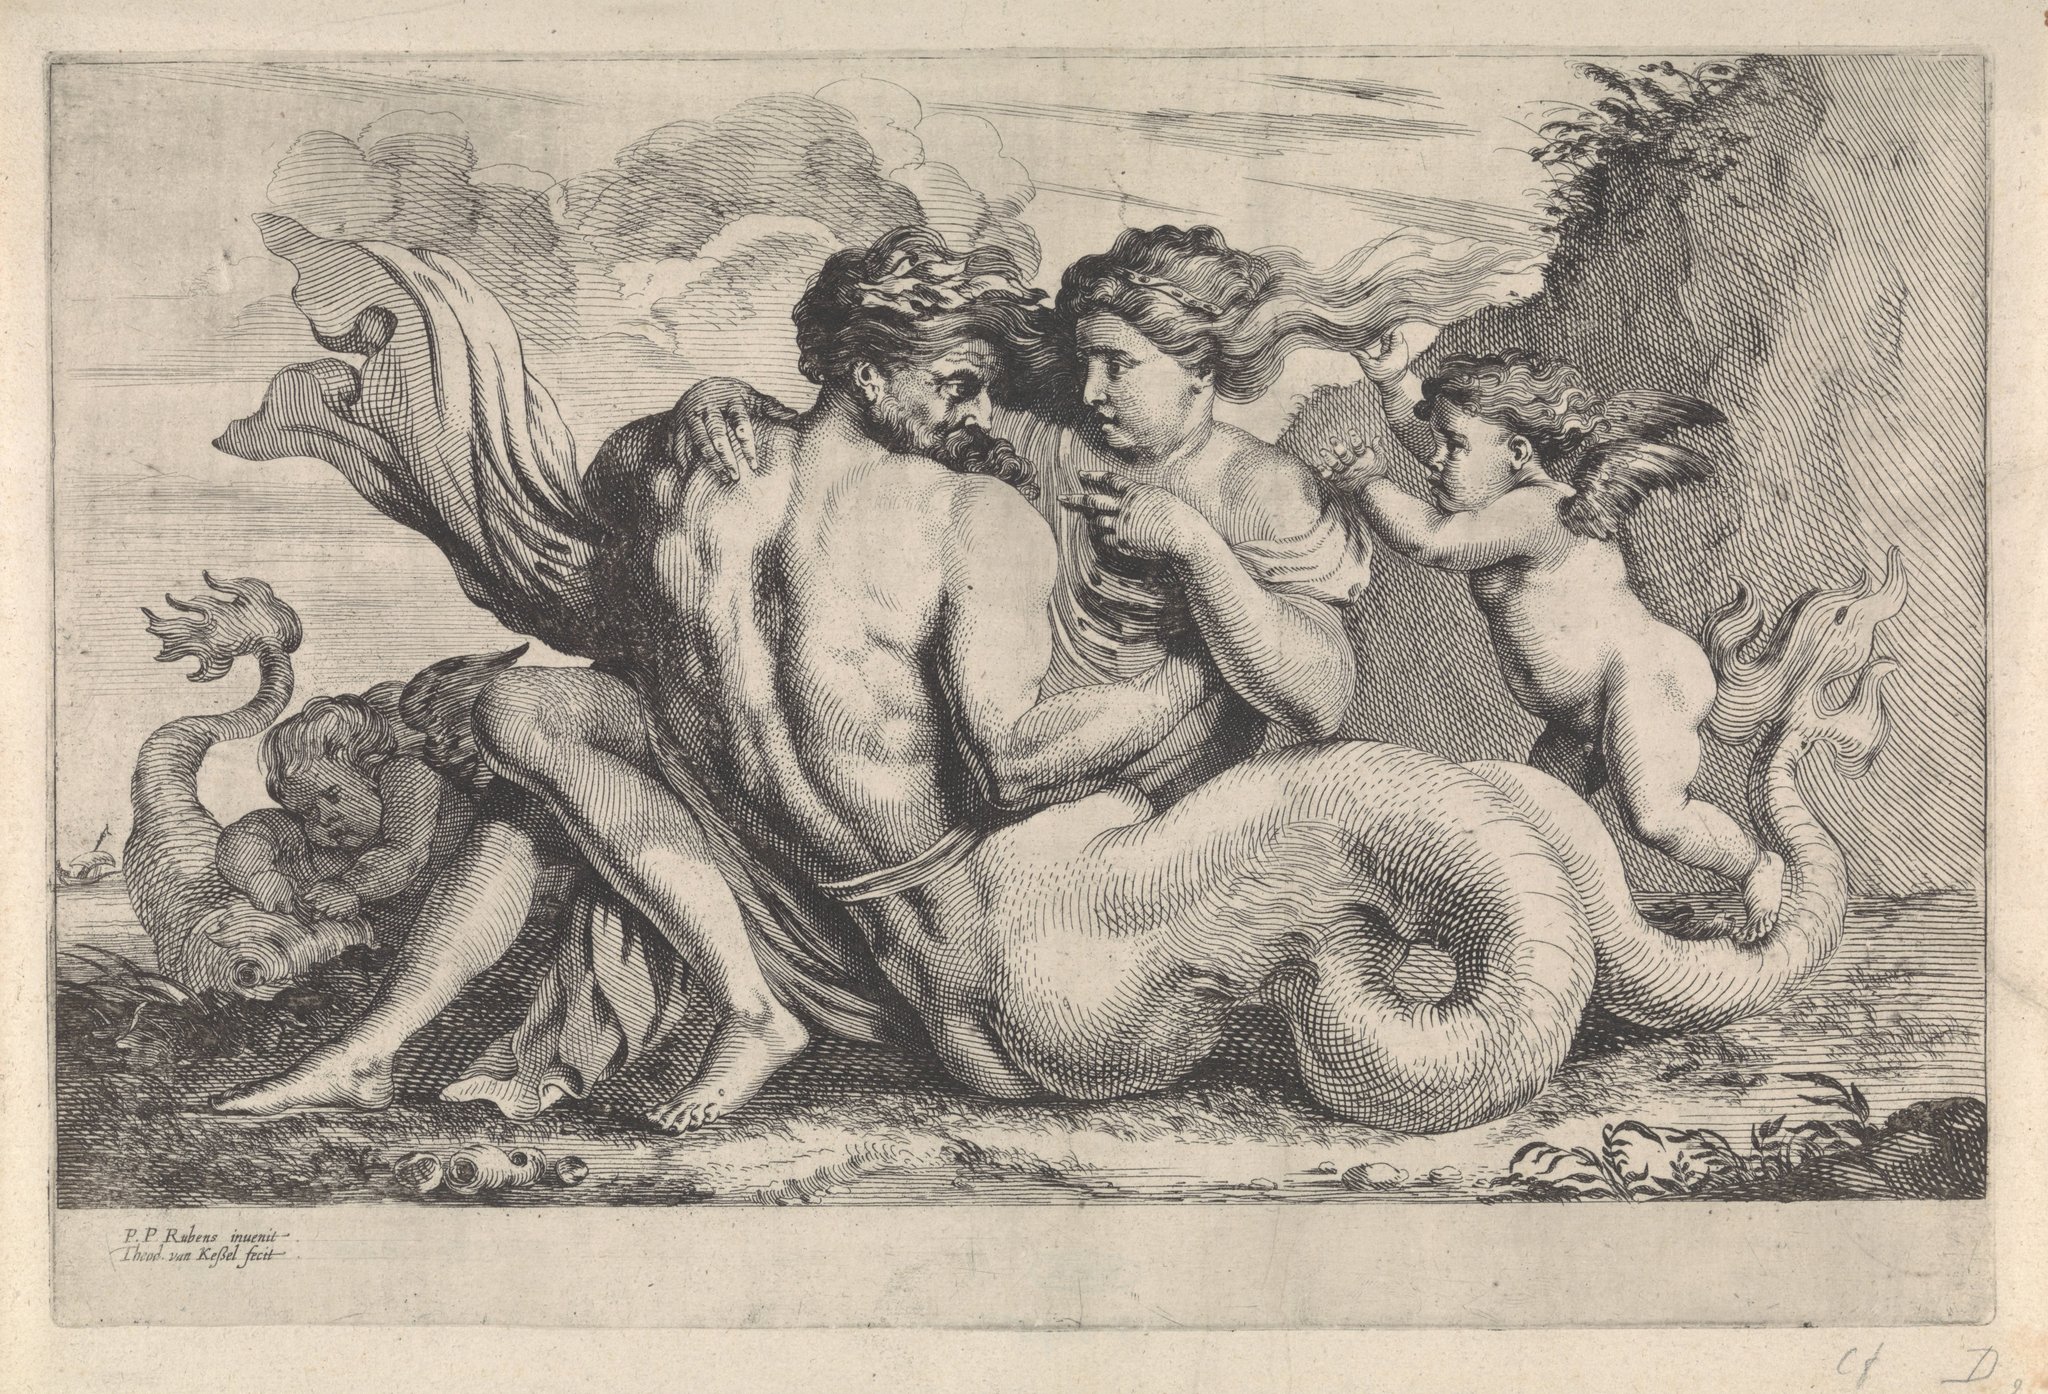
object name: print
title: Sirene en triton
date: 1630-1660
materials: paper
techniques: engraving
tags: triton(s) (+ love-affairs), sirens (classical mythology), cupids: 'amores', 'amoretti', 'putti'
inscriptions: collector's mark: Lugt 240, collector's mark: Lugt 2228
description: Aan de waterkant bevinden zich een sirene en een triton in een innige omhelzing, terwijl de wind hun haren laat wapperen. Rechts en links van het paar een putto. Deze prent maakt deel uit van een vierdelige serie over mythologische figuren.